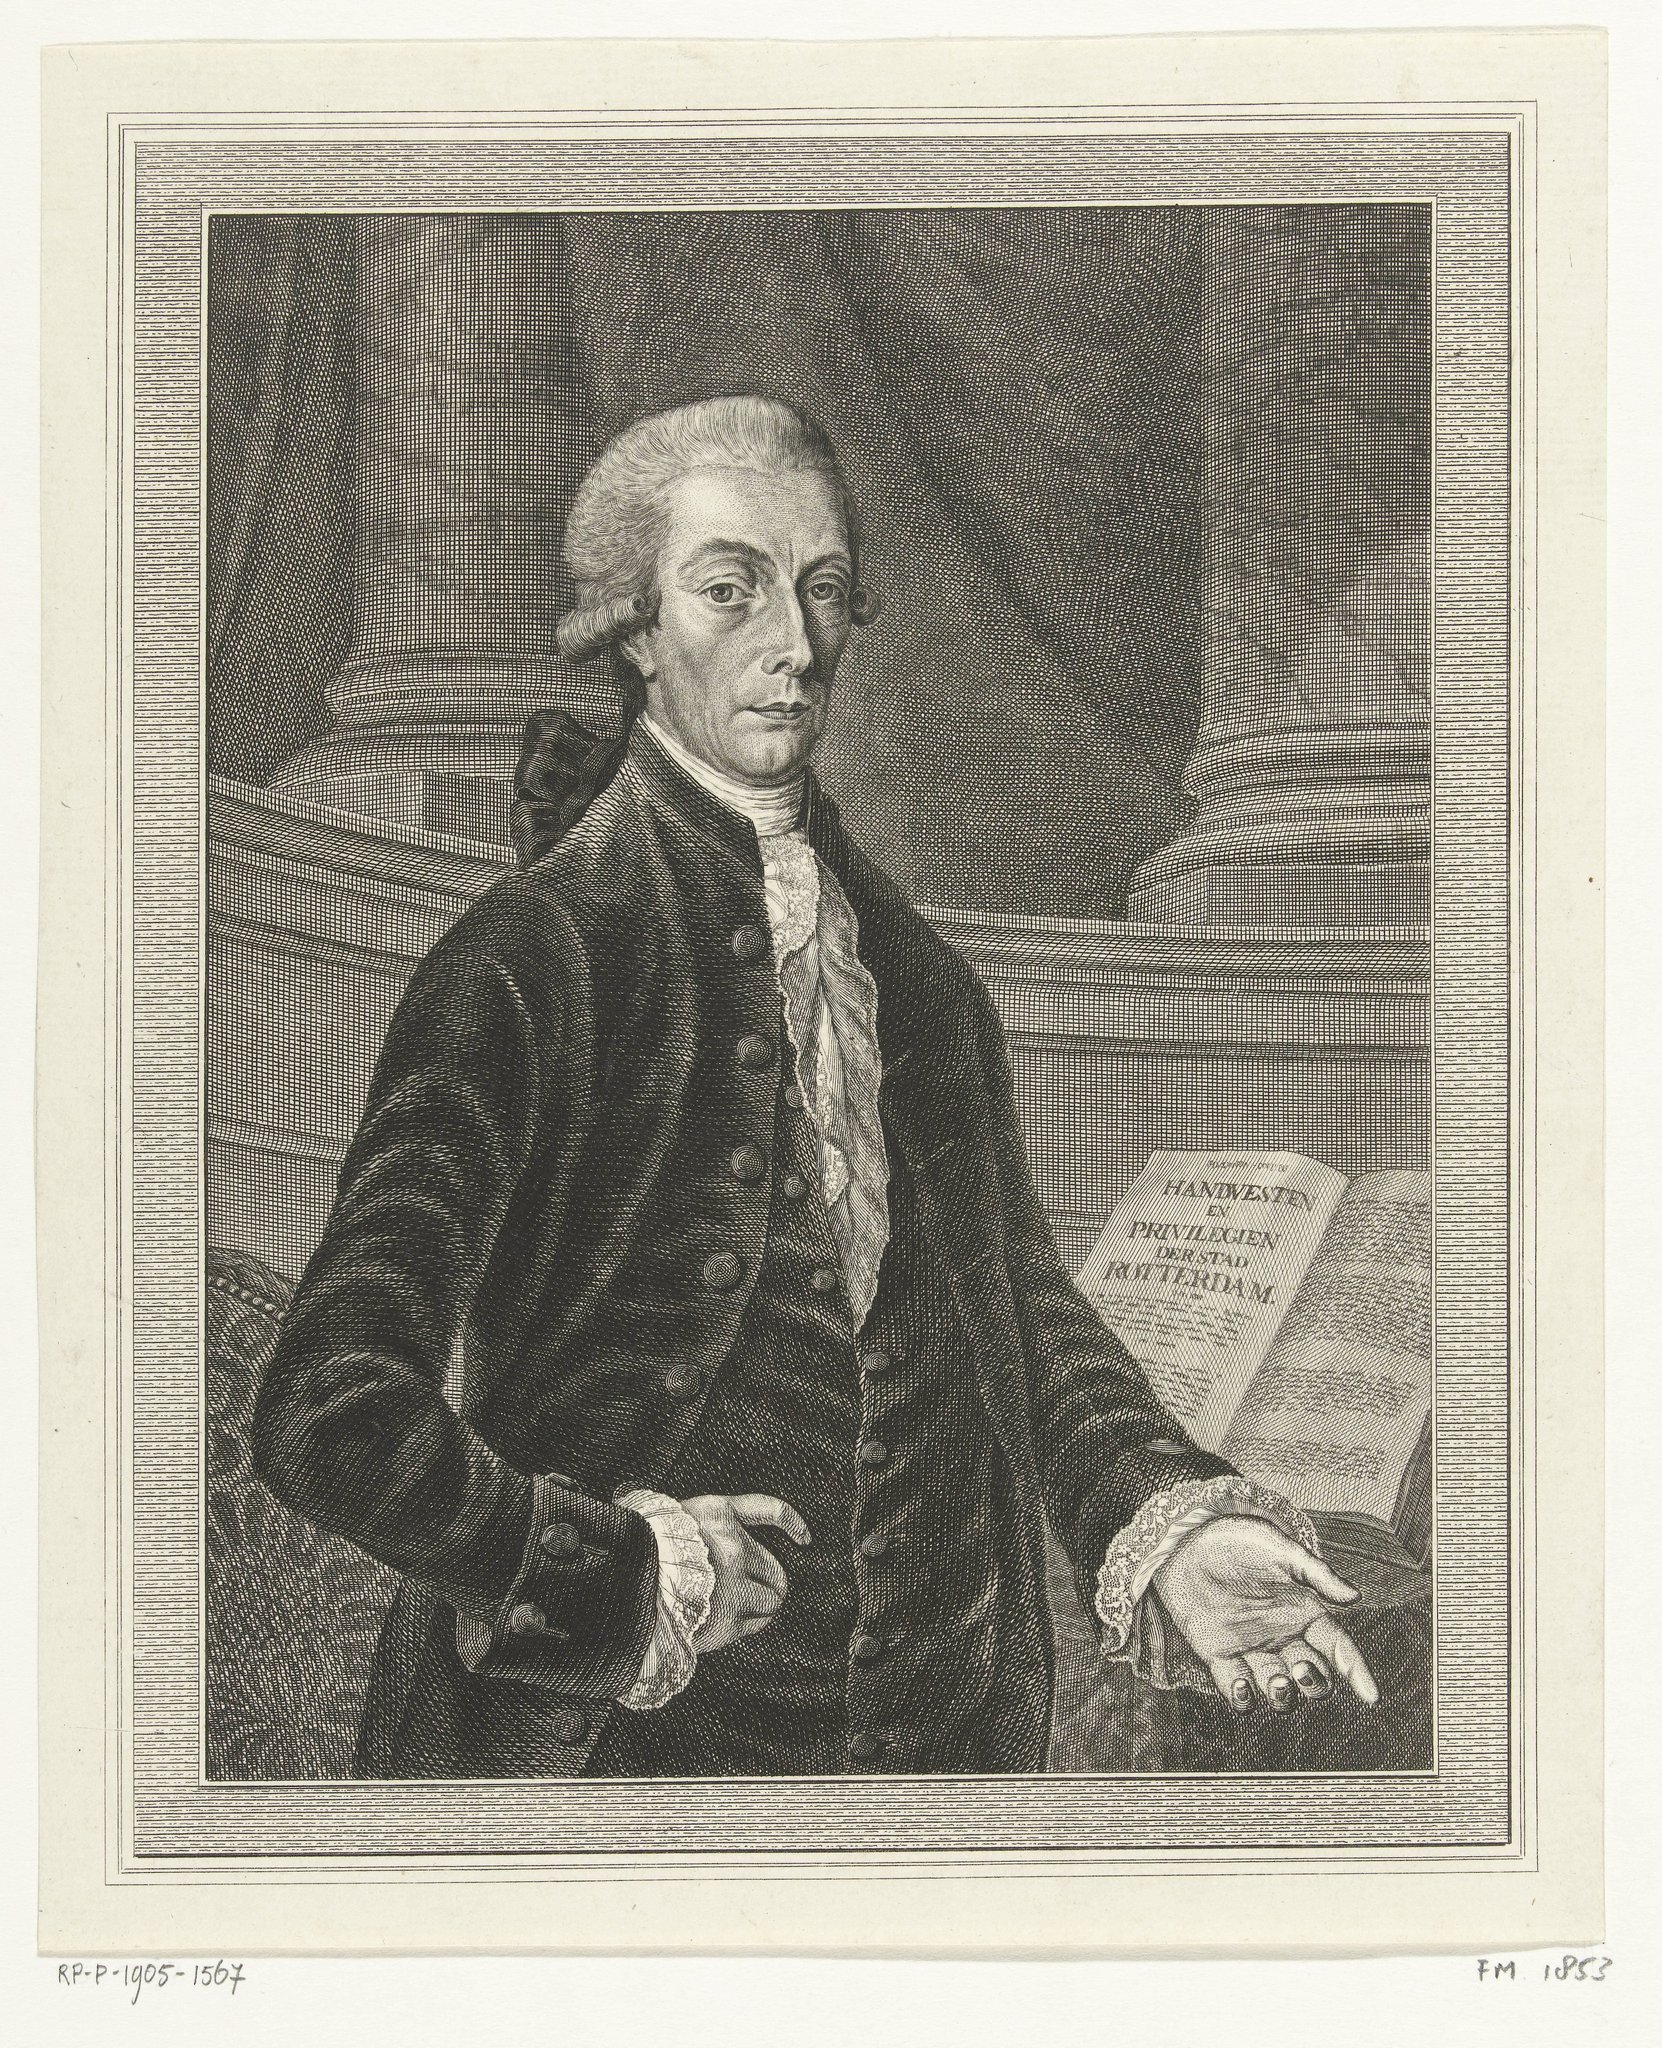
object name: print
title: Portret van Paulus Gevers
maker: leendert brasser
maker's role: draughtsman, print maker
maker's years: 1727-1793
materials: paper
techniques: engraving, etching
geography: rotterdam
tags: rotterdam, historical persons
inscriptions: collector's mark: Lugt 2228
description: Portret van Paulus Gevers staand naast tafel met opengeslagen handboek dat verwijst naar zijn beroep als hoofdofficier van de stad Rotterdam.